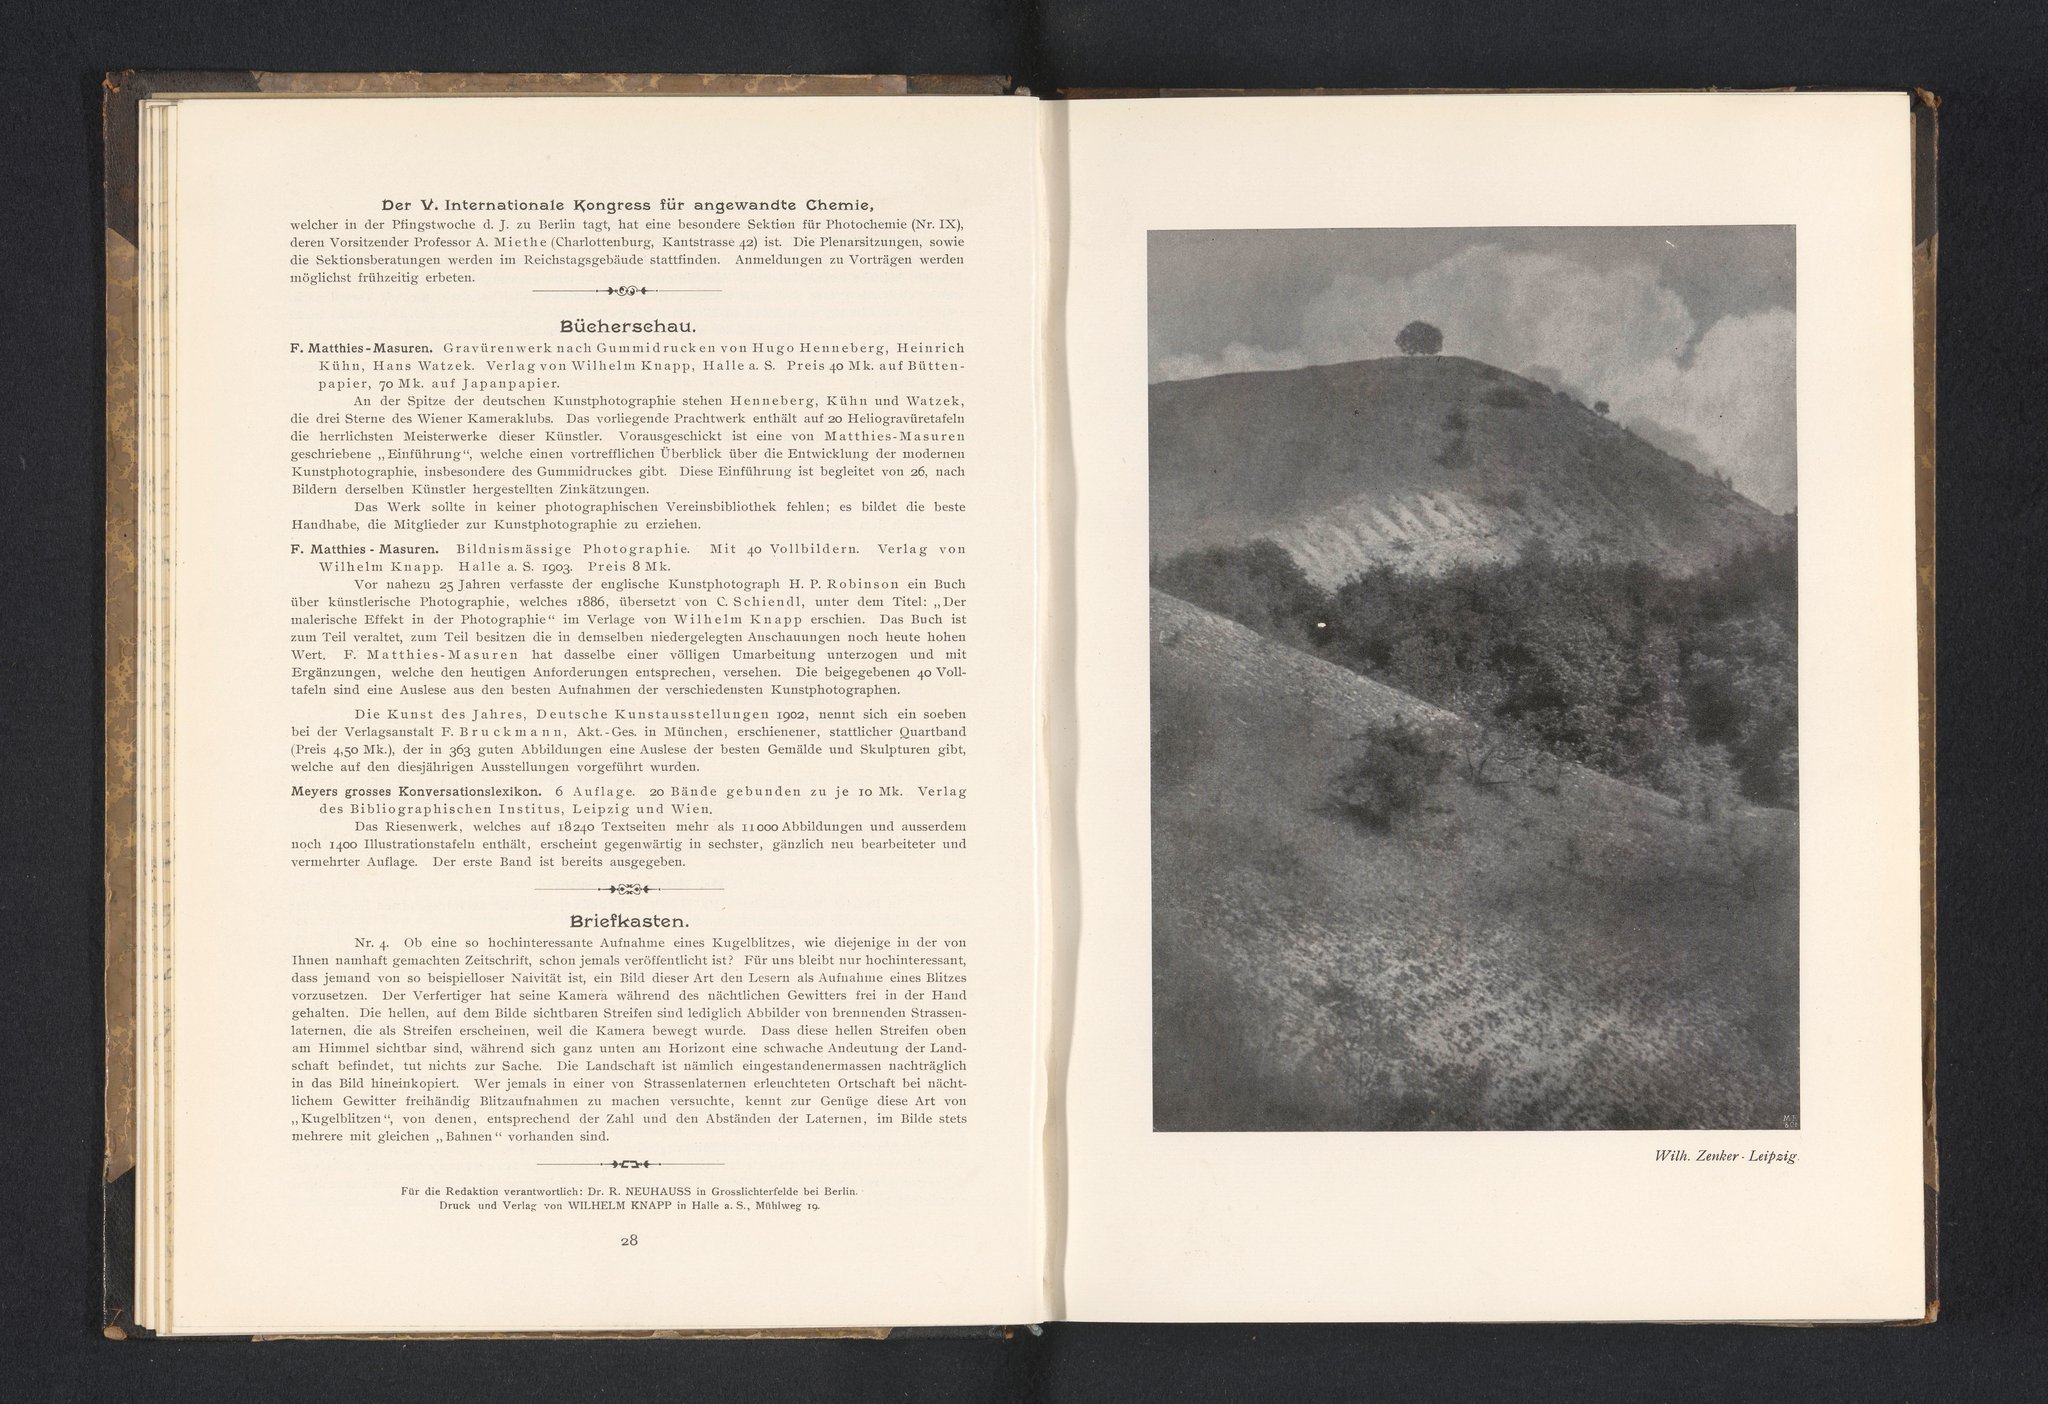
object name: photomechanical print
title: Heuvelachtig landschap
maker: wilh. zenker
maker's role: fotograaf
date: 1898-1903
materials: paper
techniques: autotype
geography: berlin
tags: landscapes, (high) hill